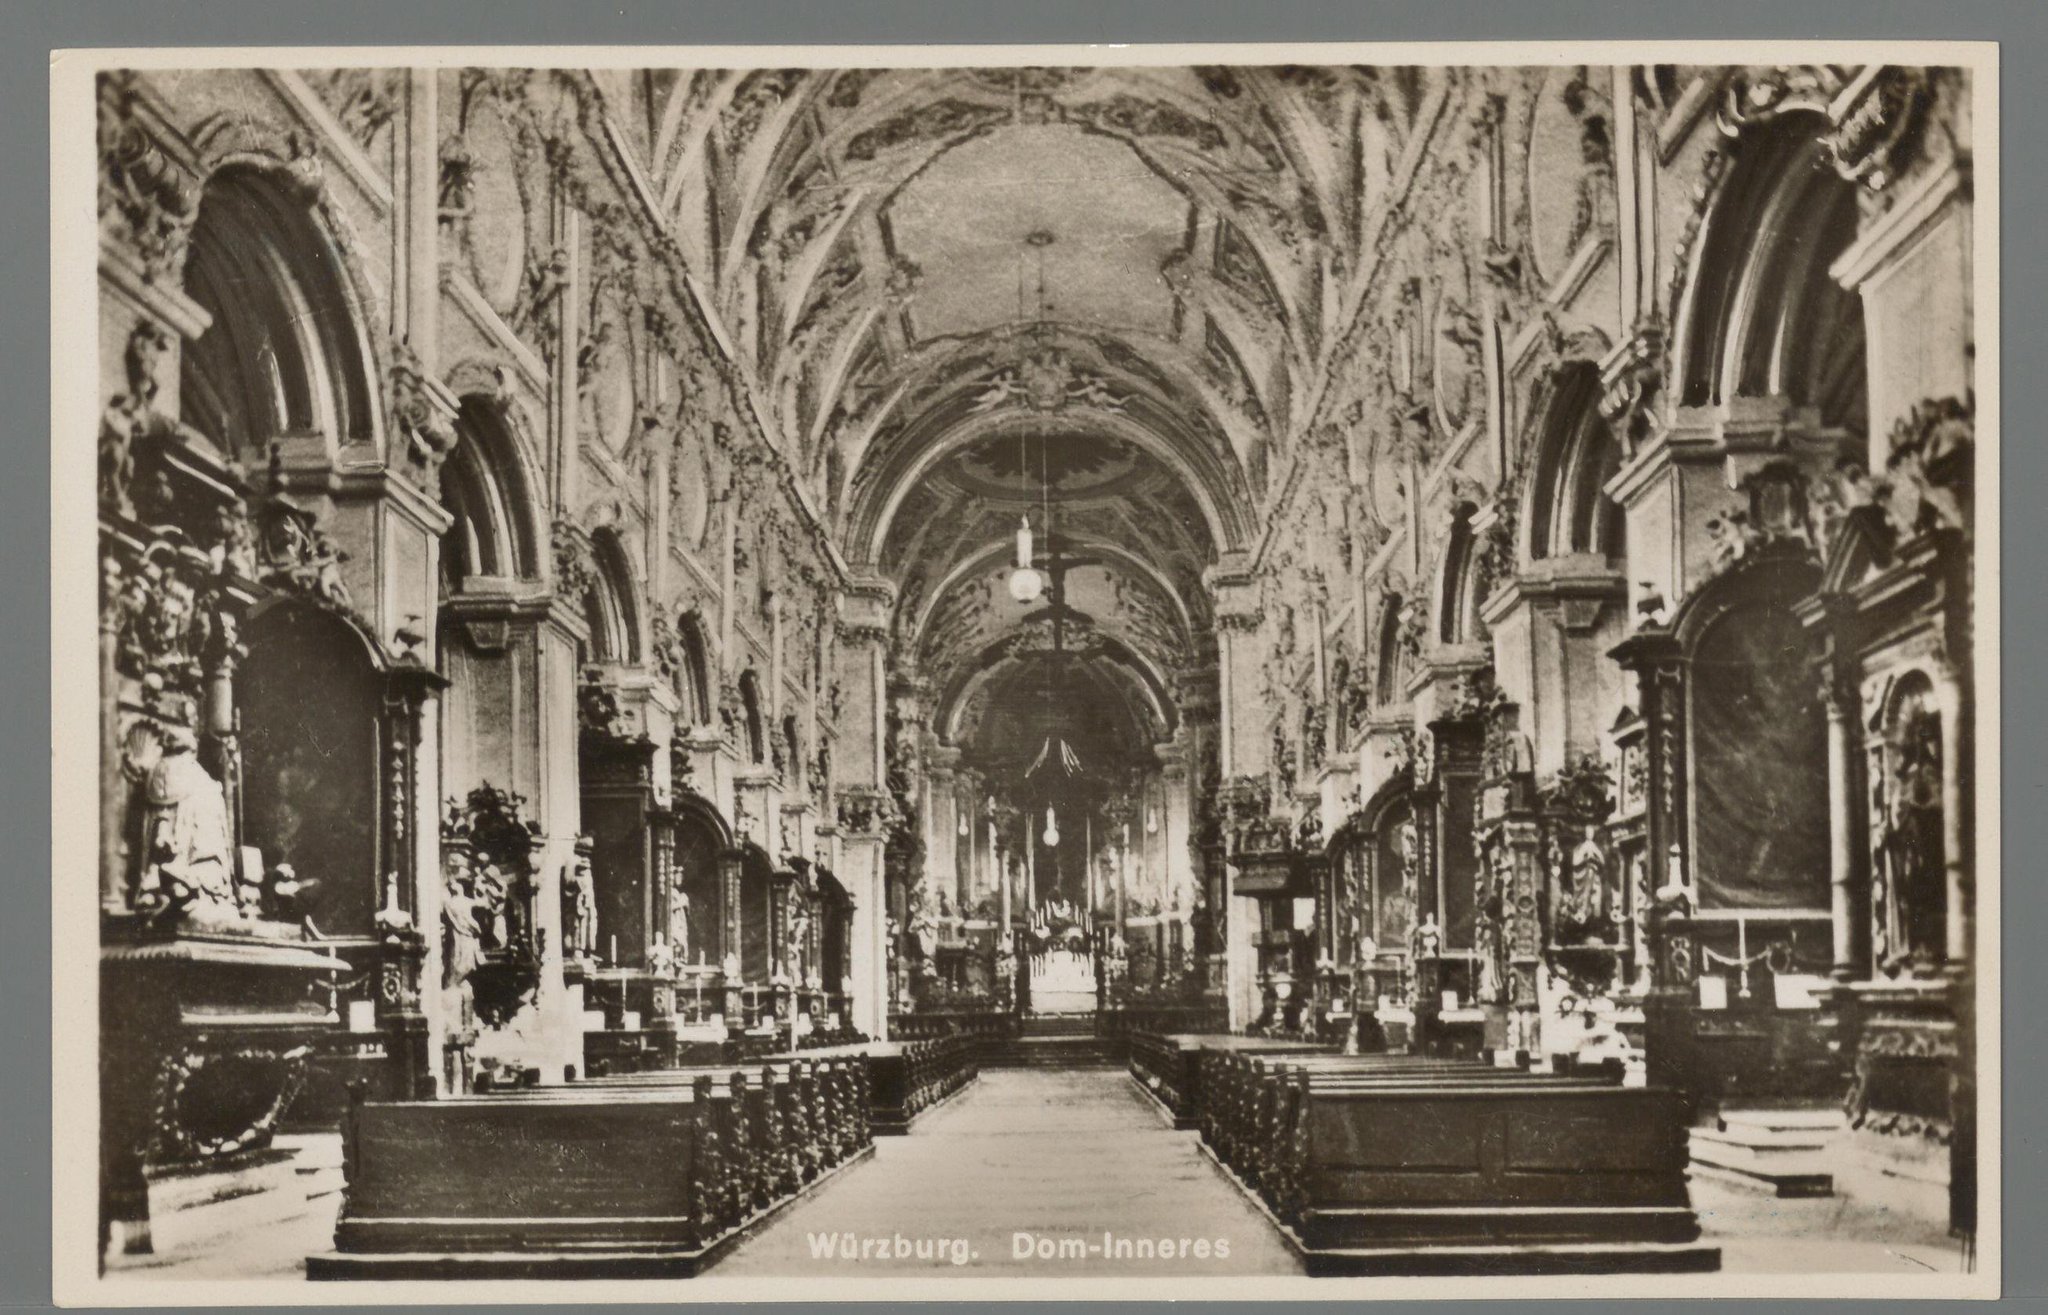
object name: photograph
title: Würzburg. Dom-Inneres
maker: Anonymous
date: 1932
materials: photographic support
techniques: photography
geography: würzburg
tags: interior of church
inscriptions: date